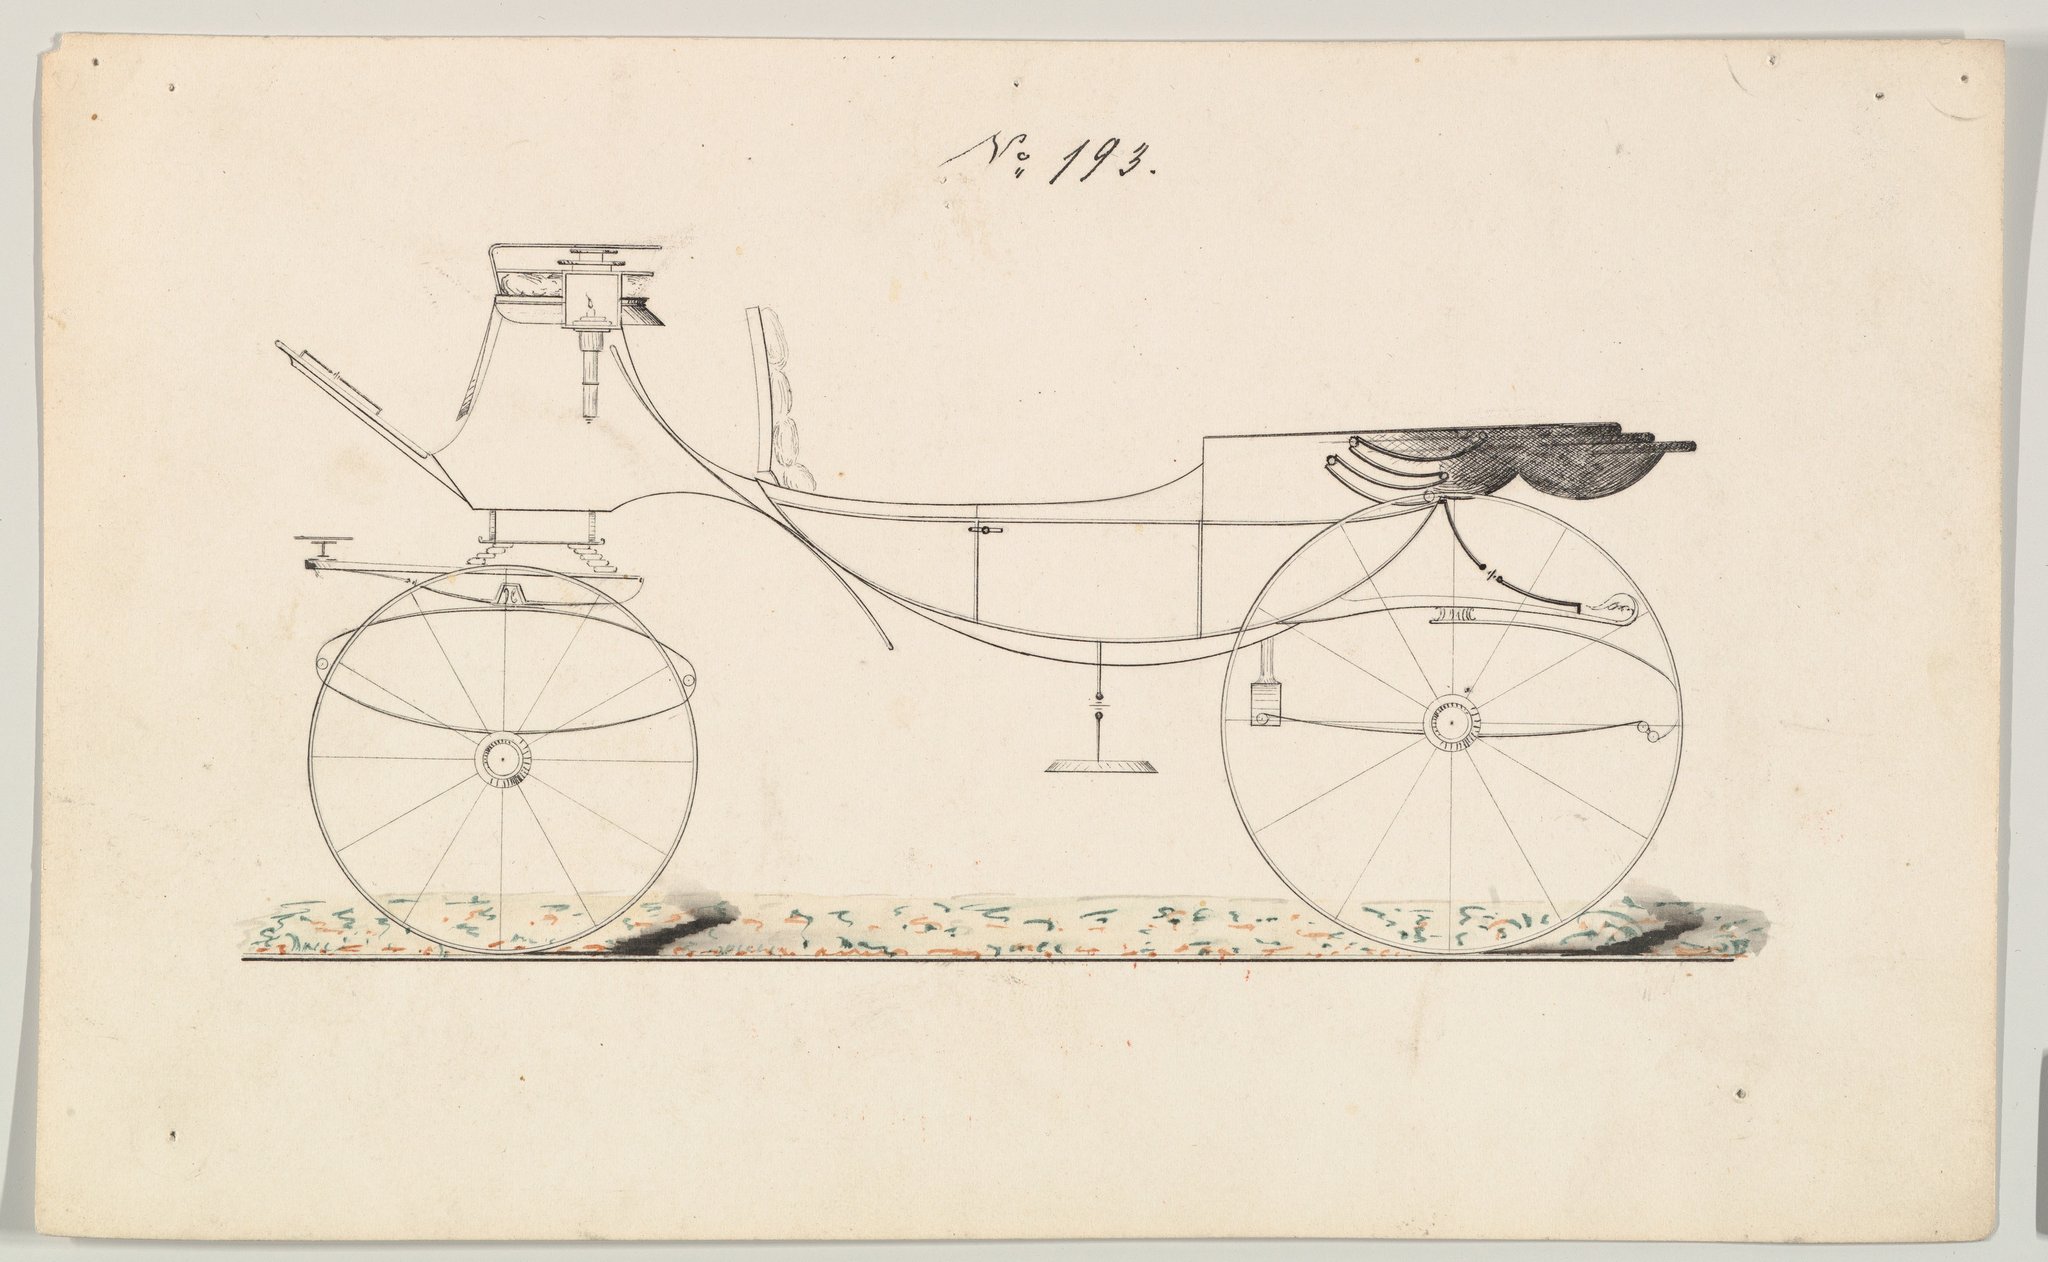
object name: drawing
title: Design for Vis-à-vis/ Brougham, no. 193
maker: brewster & co.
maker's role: manufacturer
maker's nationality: american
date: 1850-1870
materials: gouache, ink, watercolor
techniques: pen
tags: carriages